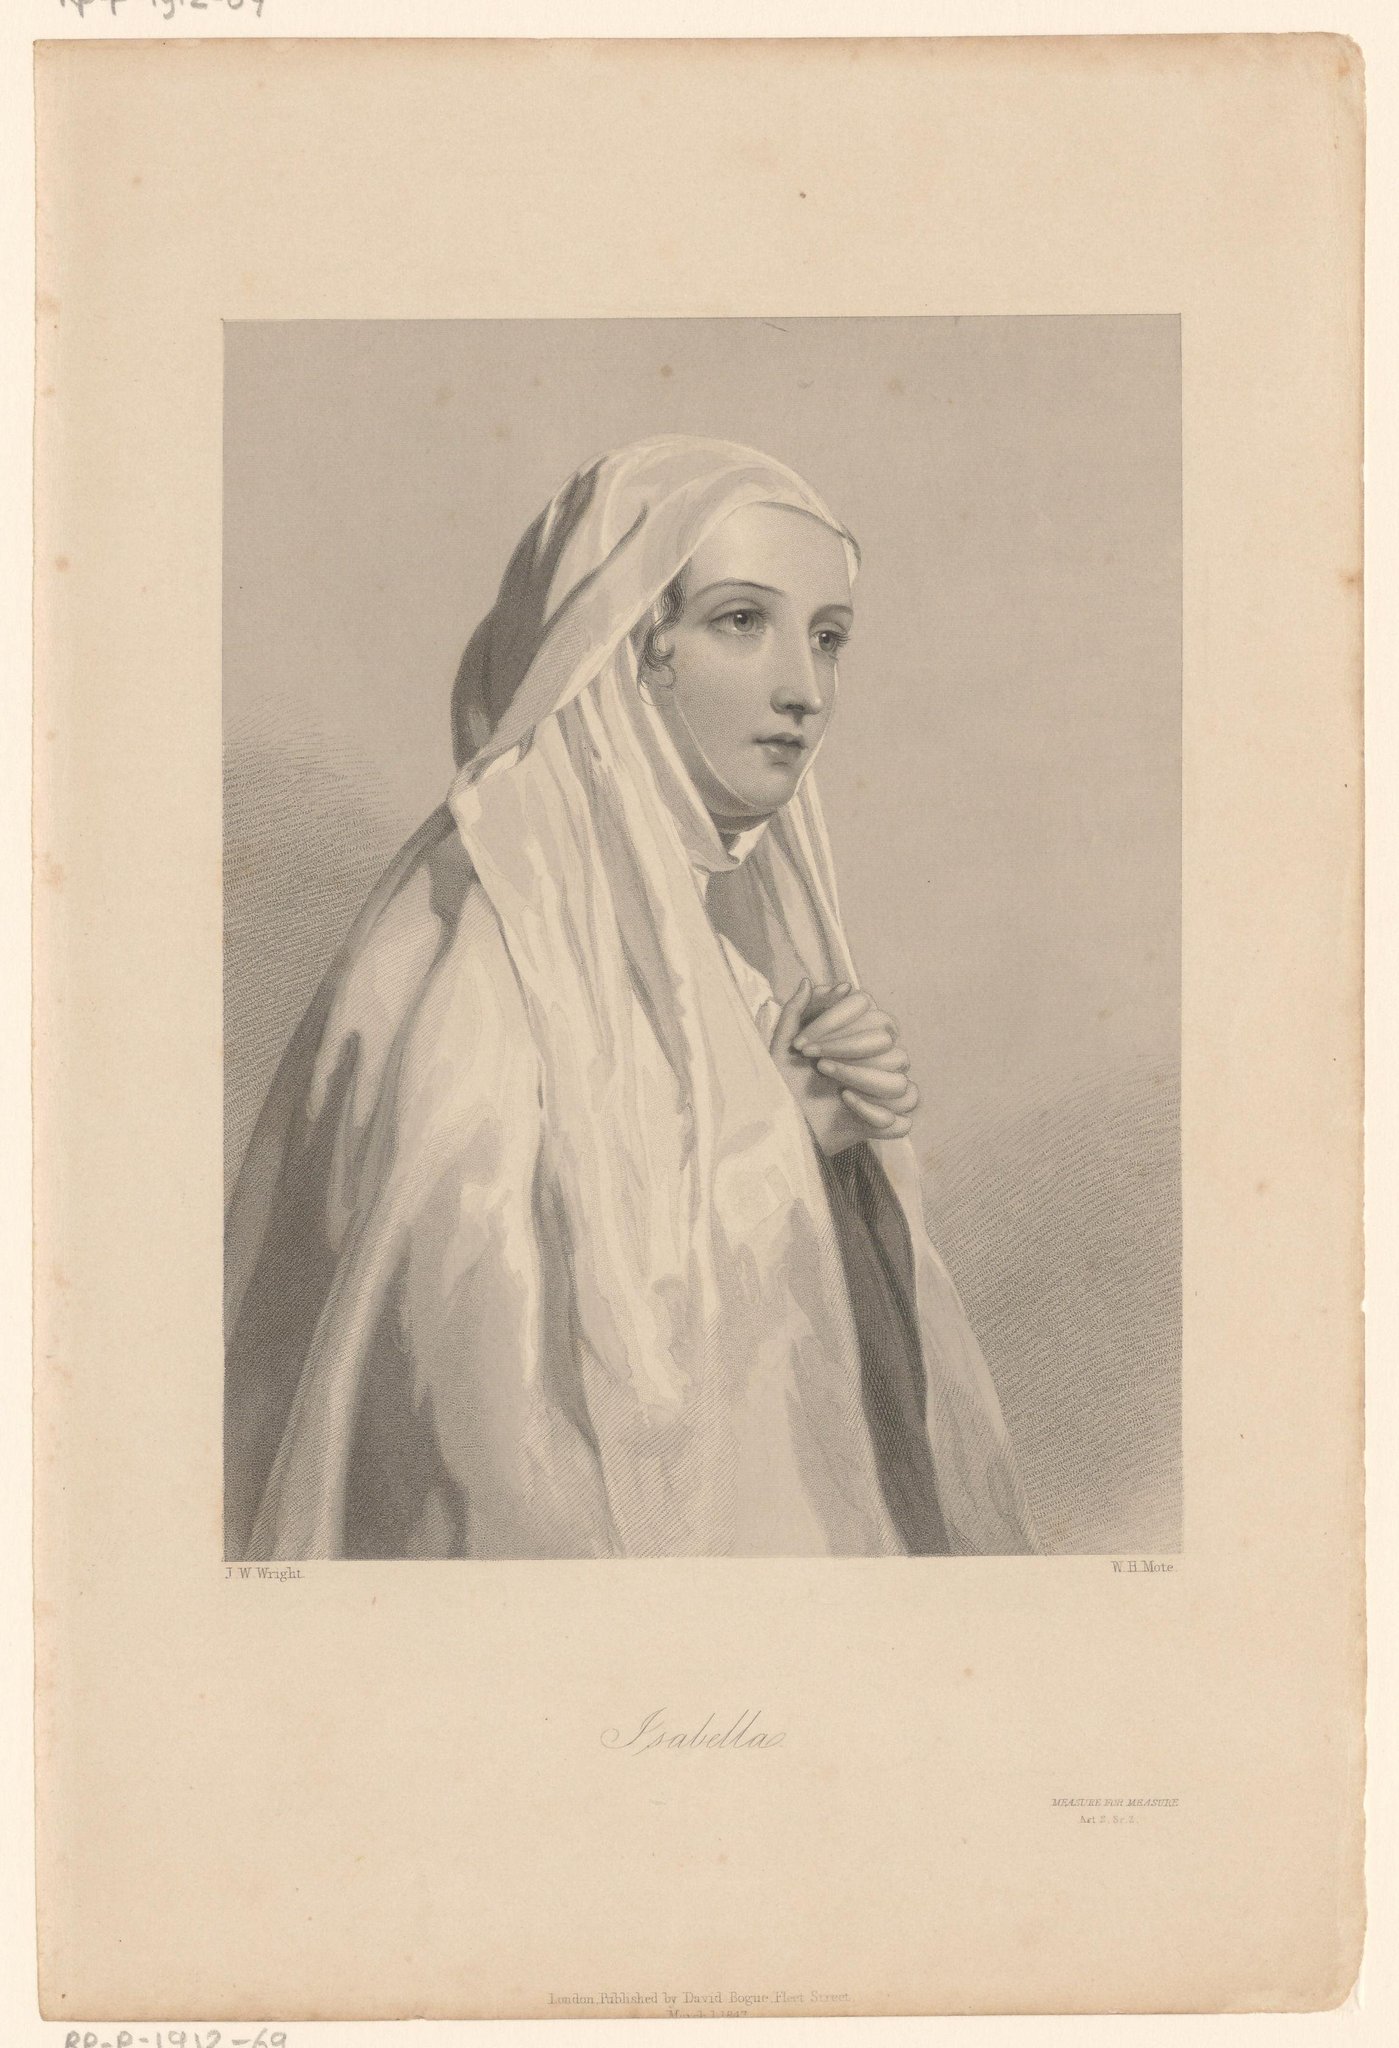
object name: book illustration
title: Isabella, uit Shakespeares Leer om leer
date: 1803-1847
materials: paper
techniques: etching, roulette, engraving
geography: london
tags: william shakespeare, female literary characters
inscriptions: collector's mark: Lugt 2228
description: Prent ook gebruikt in: Heath, Charles. The heroines of Shakespeare: comprising the principal female characters in the plays of the great poet. Londen: David Bogue, 1848.